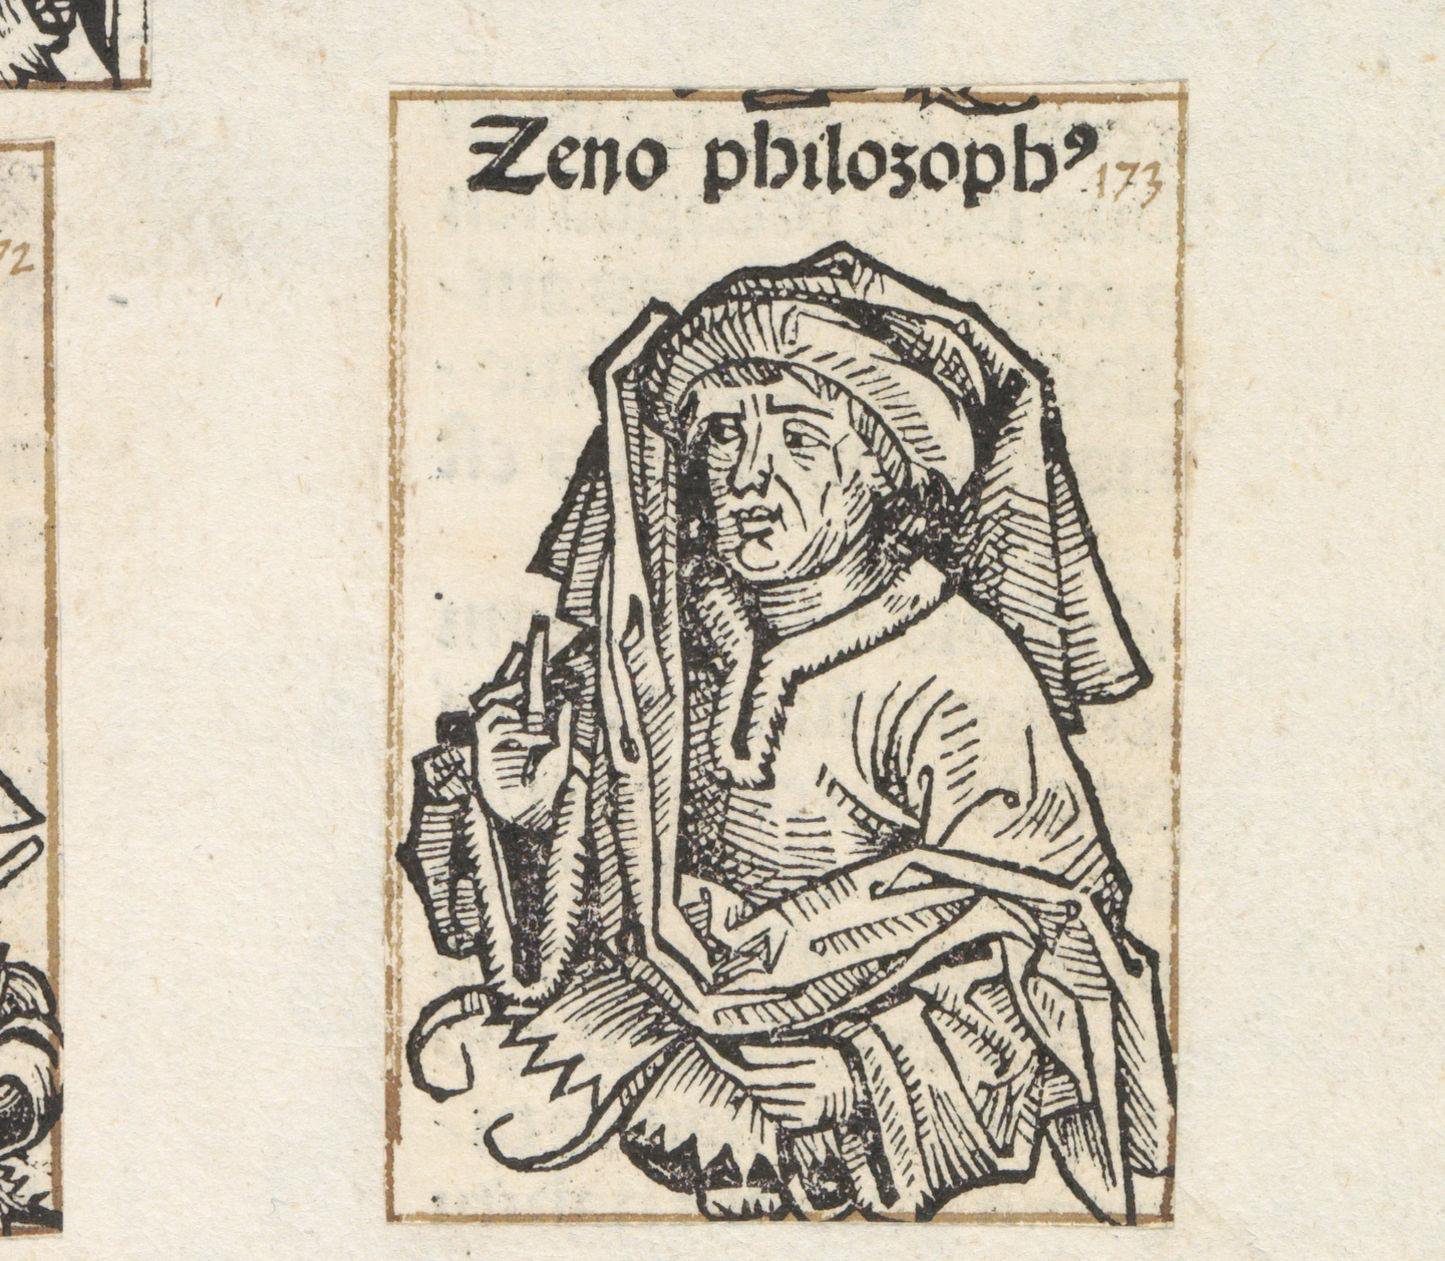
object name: print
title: Liber Chronicarum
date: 1493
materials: paper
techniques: letterpress printing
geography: nuremberg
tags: male persons from classical history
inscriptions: inscription: ‘173’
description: De houtsnede wordt gebruikt als boekillustratie in de Liber Chronicarum (of Neurenbergkroniek) van Hartmann Schedel, verschenen in het Latijn en Duits in 1493. Zie de Latijnse uitgave, folio 73r.